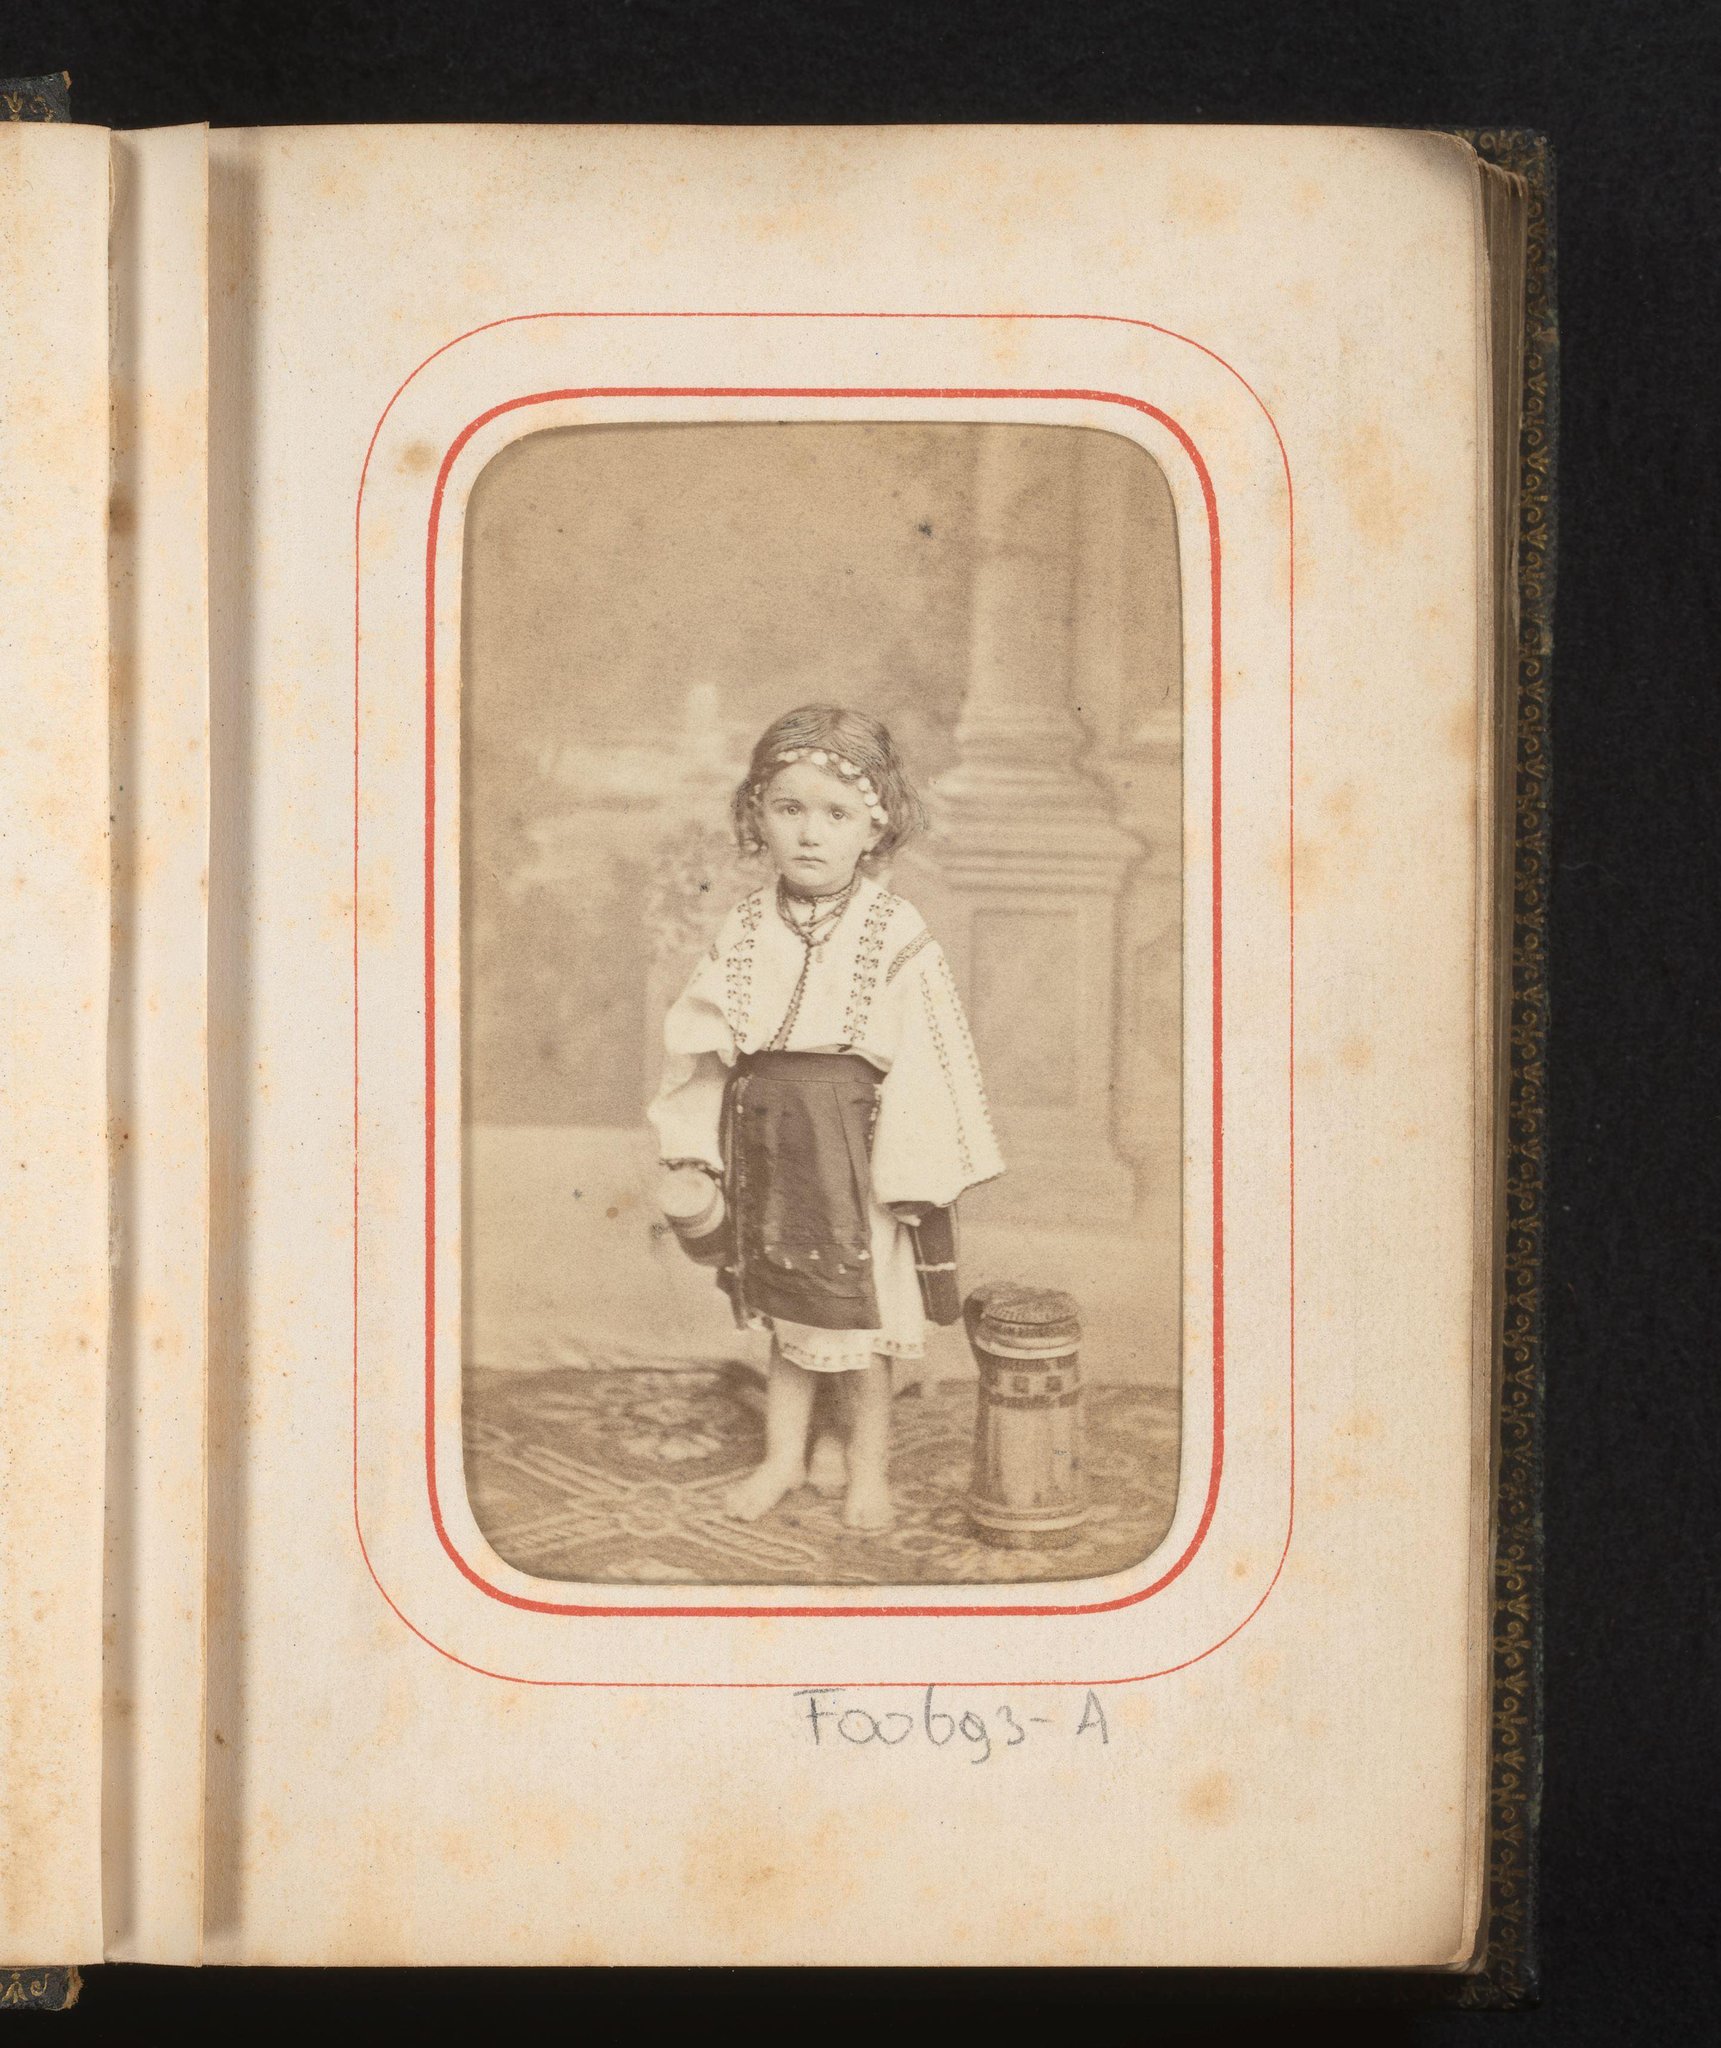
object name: photograph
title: Portret van een jong kind in Roemeense klederdracht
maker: franz duschek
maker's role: fotograaf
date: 1870-1890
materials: cardboard, photographic support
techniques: albumen print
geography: bucharest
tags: historical persons, folk costume, regional costume, tot, toddler ~ the ages of man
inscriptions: inscription: ‘F. DUSCHEK/ strada nouà/ linga Sala Slatineanu/ BUCURESCI.’